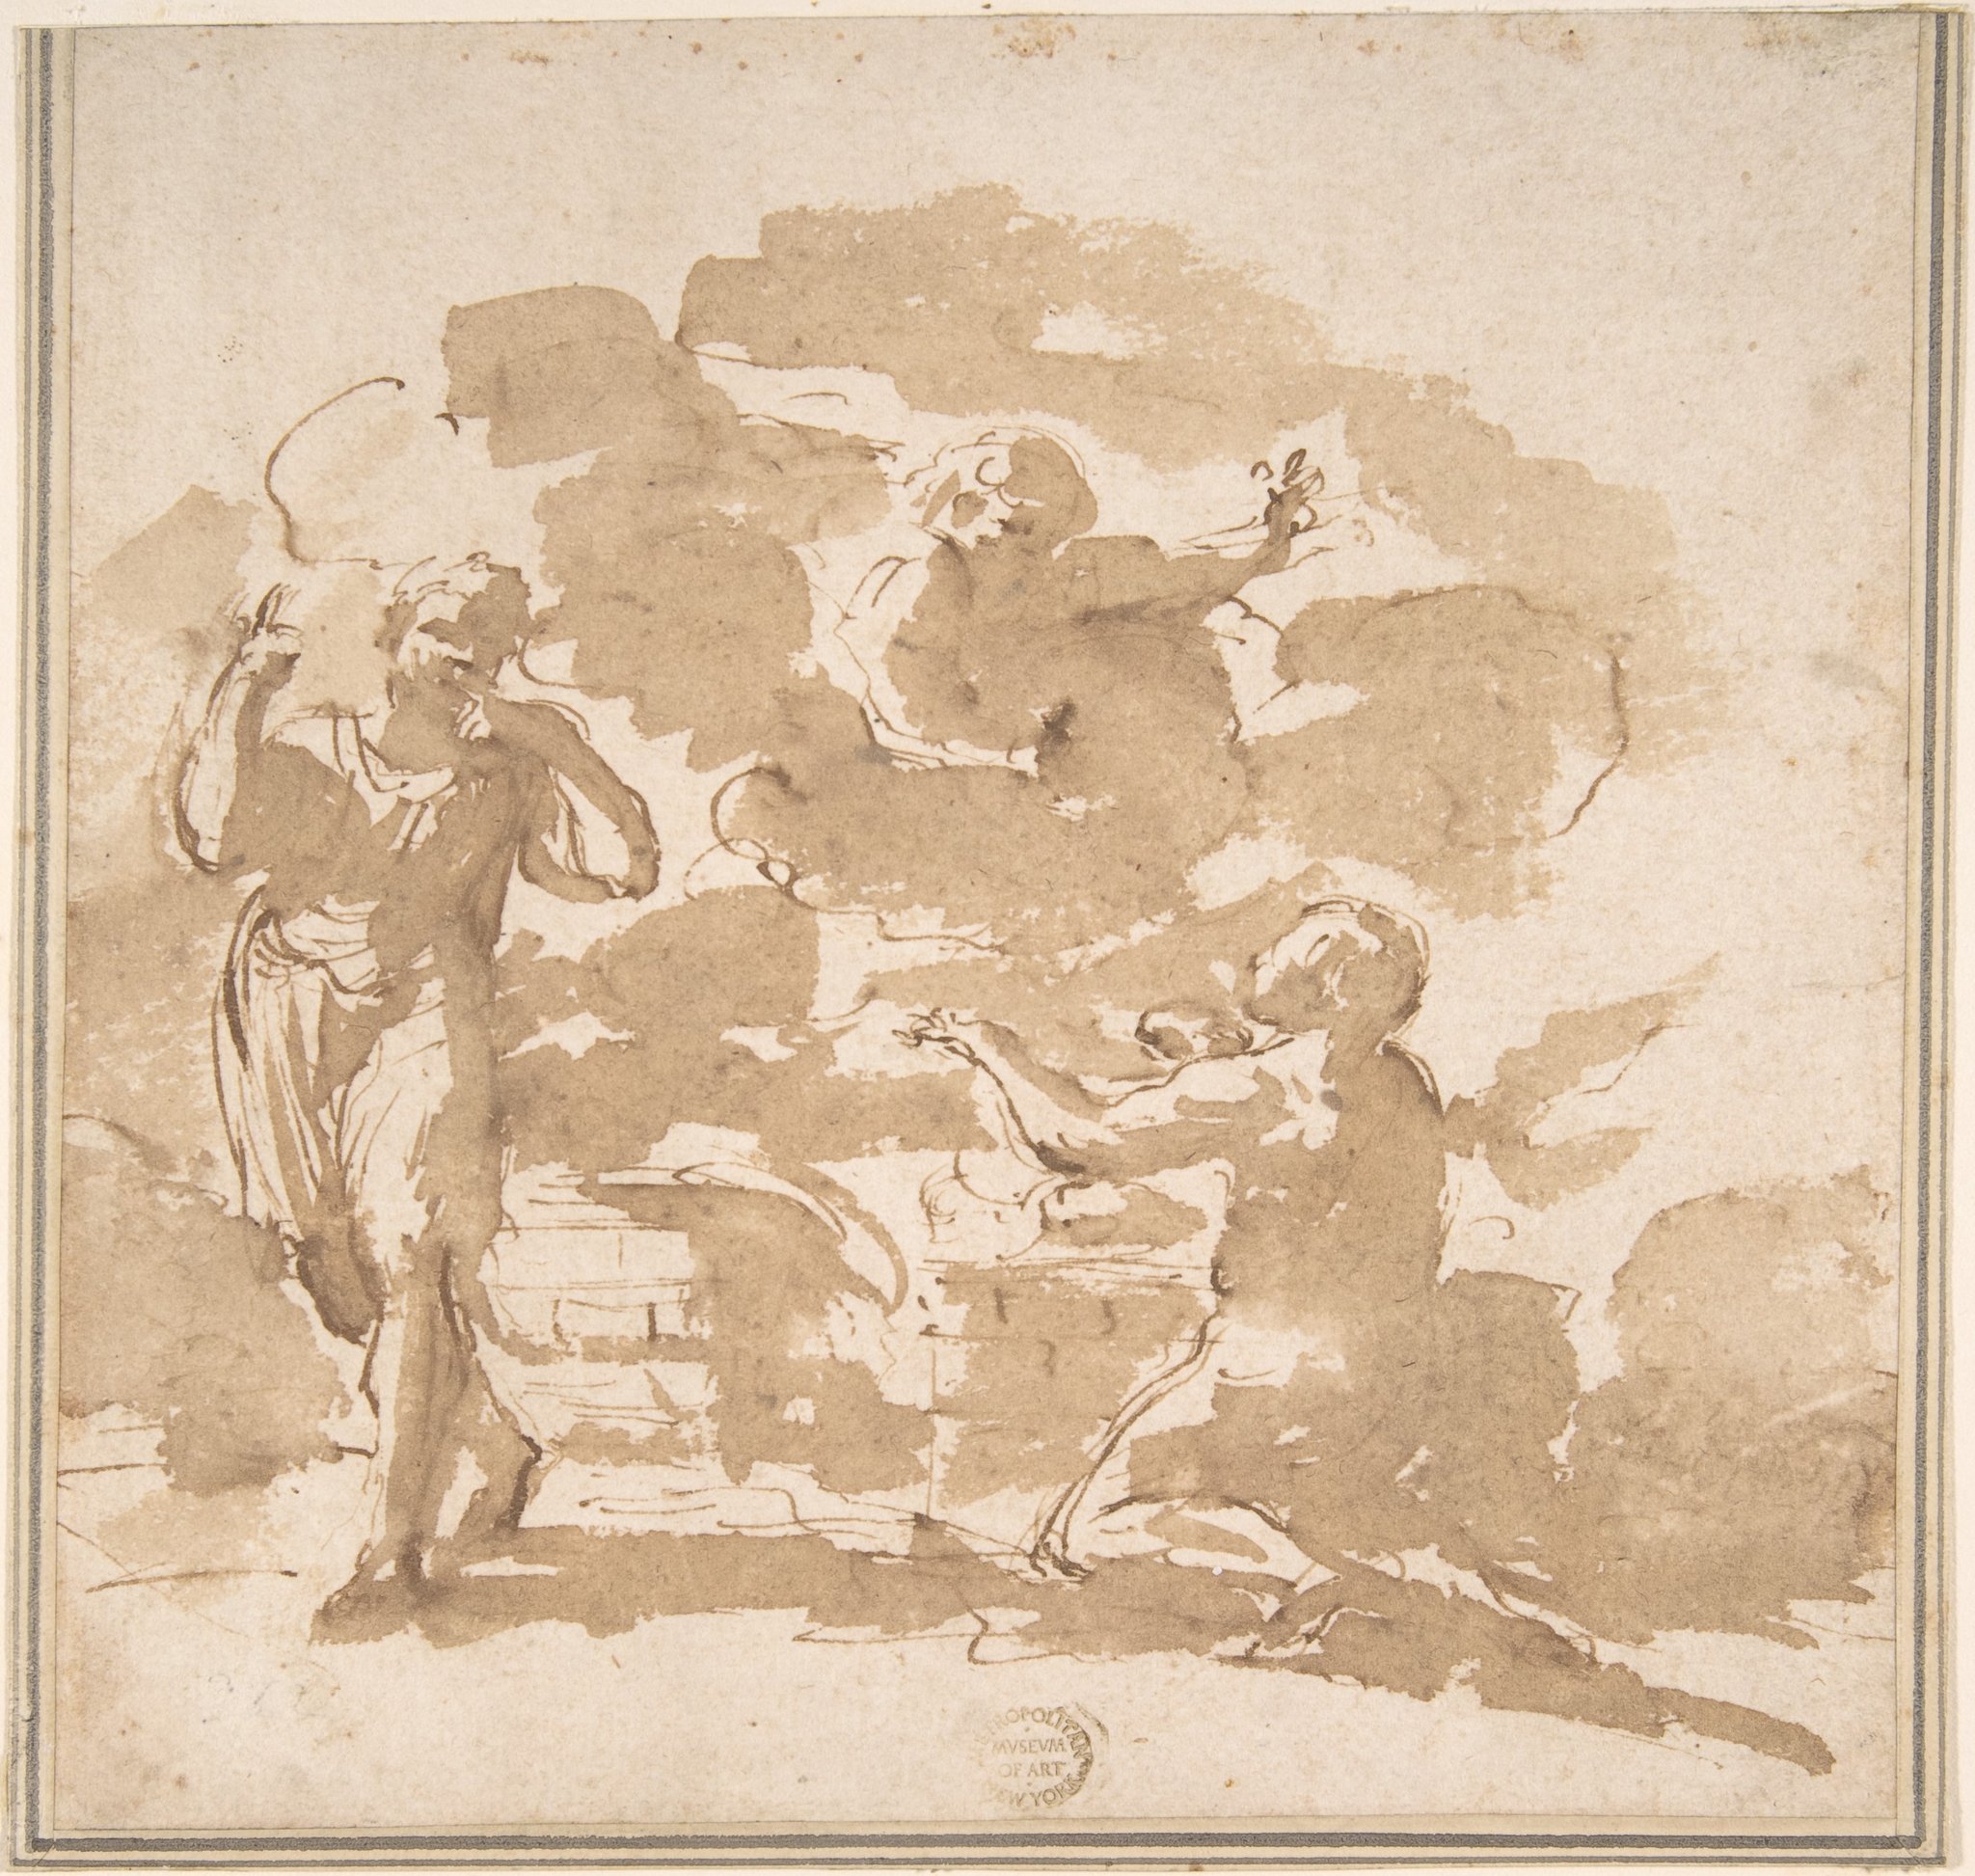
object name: drawing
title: The Sacrifice of Abel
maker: anonymous, italian, roman-bolognese, 17th century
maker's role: artist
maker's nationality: italian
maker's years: 1600-1700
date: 1601-1700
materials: ink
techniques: brush, pen, wash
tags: human figures,abel